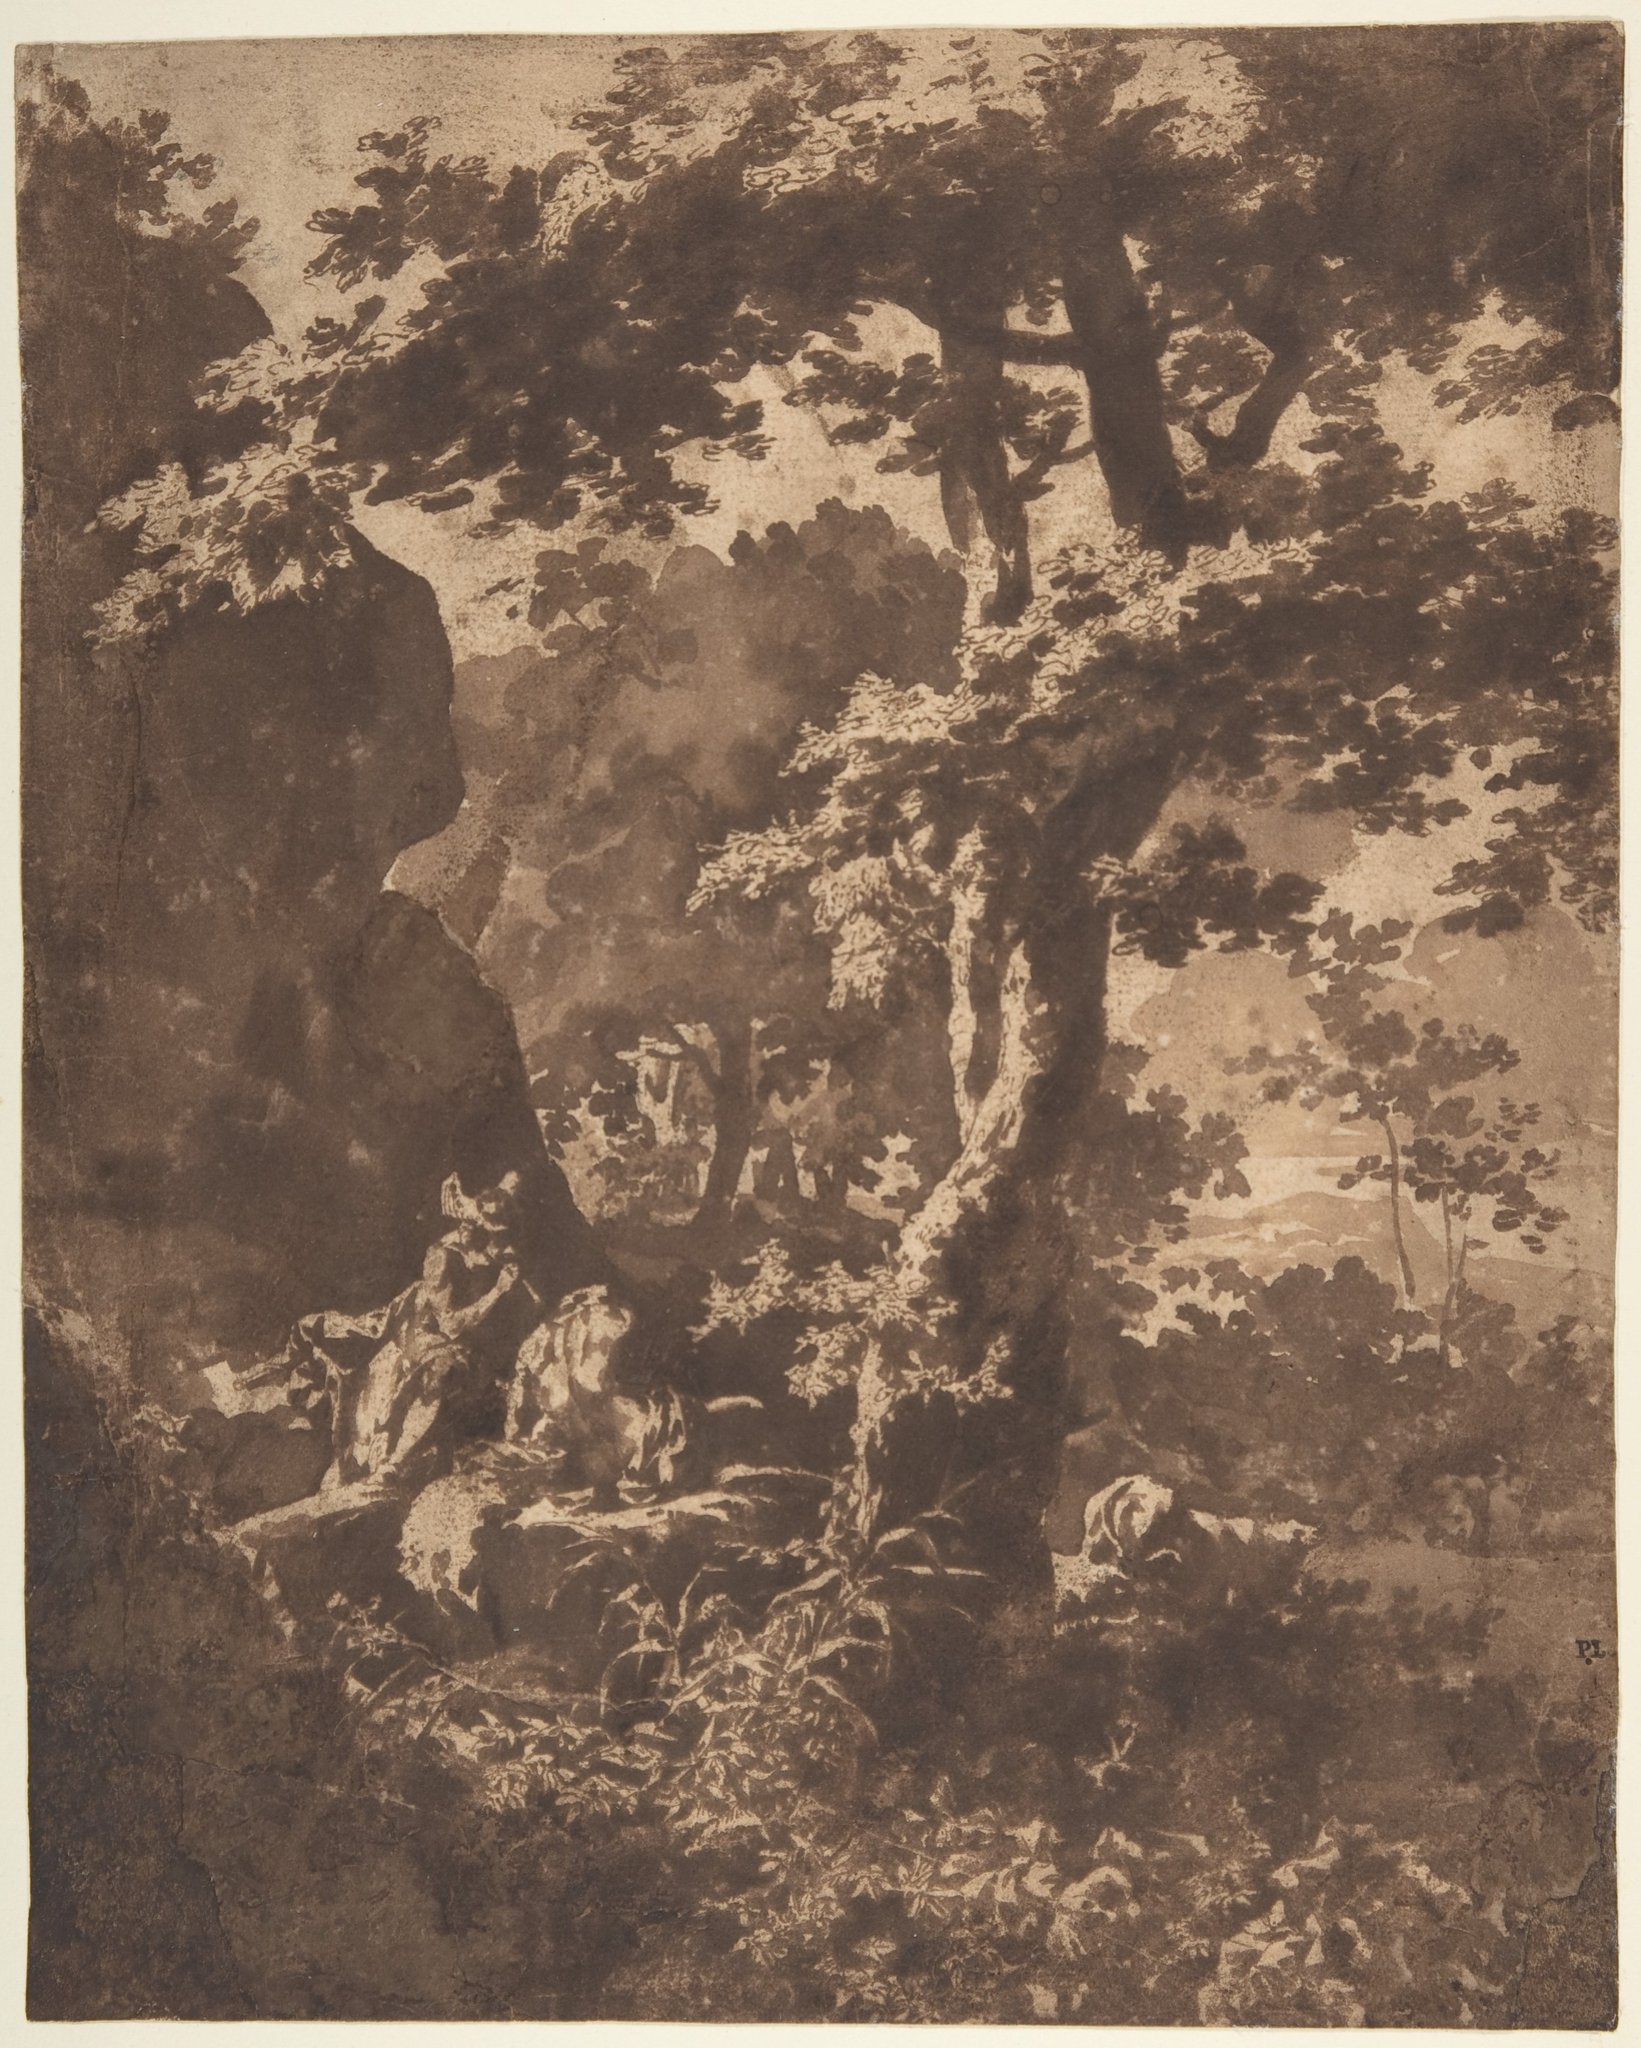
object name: drawing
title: Mercury Lulling Argus to Sleep in a Landscape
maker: jan de bisschop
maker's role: artist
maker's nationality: dutch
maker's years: 1628-1671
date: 1634-1666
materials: ink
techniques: brush, pen, wash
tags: mercury,landscapes,trees